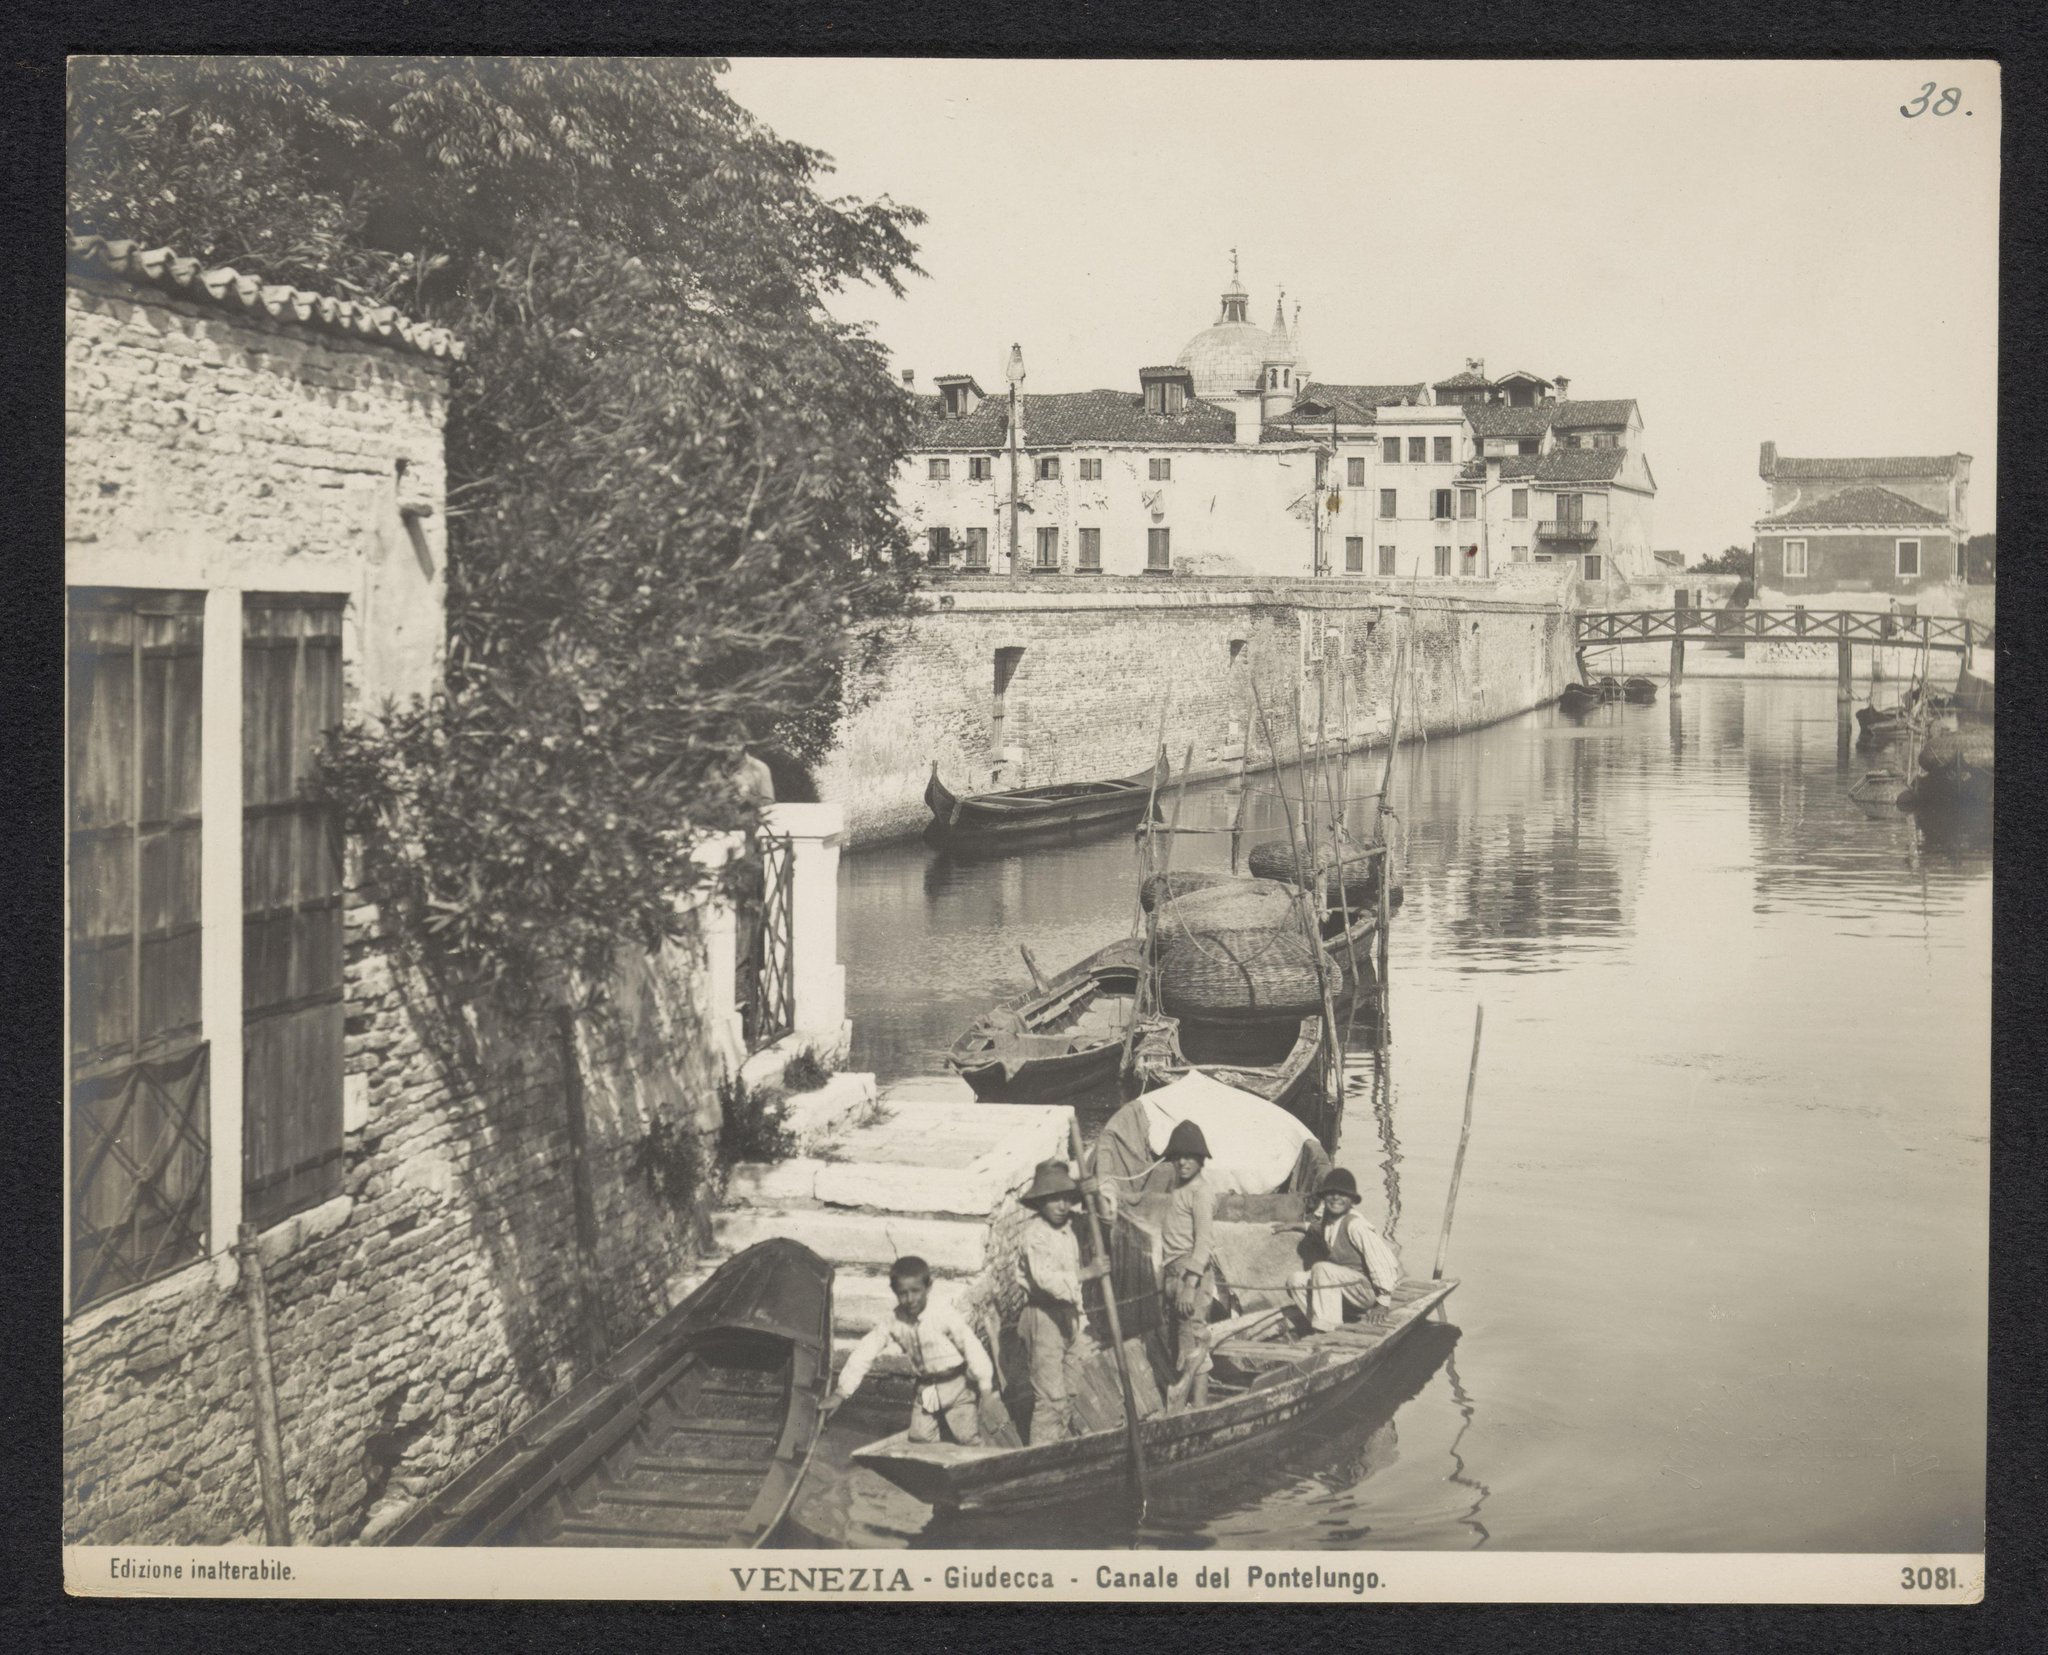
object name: photograph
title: Venezia - Giudecca - Canale del Pontelungo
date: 1900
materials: cardboard, photographic support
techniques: gelatin silver print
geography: venice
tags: canal, gondola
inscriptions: number: ‘3081.’, number: ‘38.’